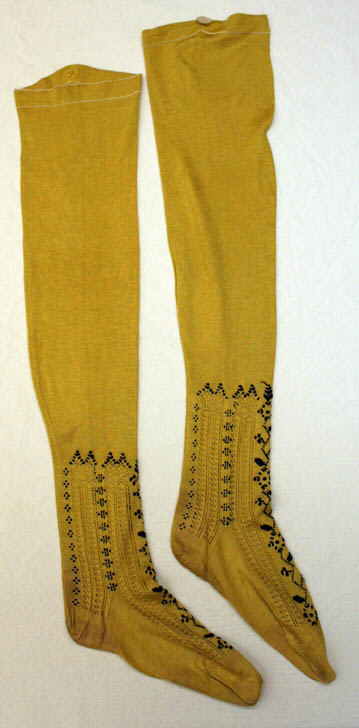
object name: stocking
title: Stockings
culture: french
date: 1882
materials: silk